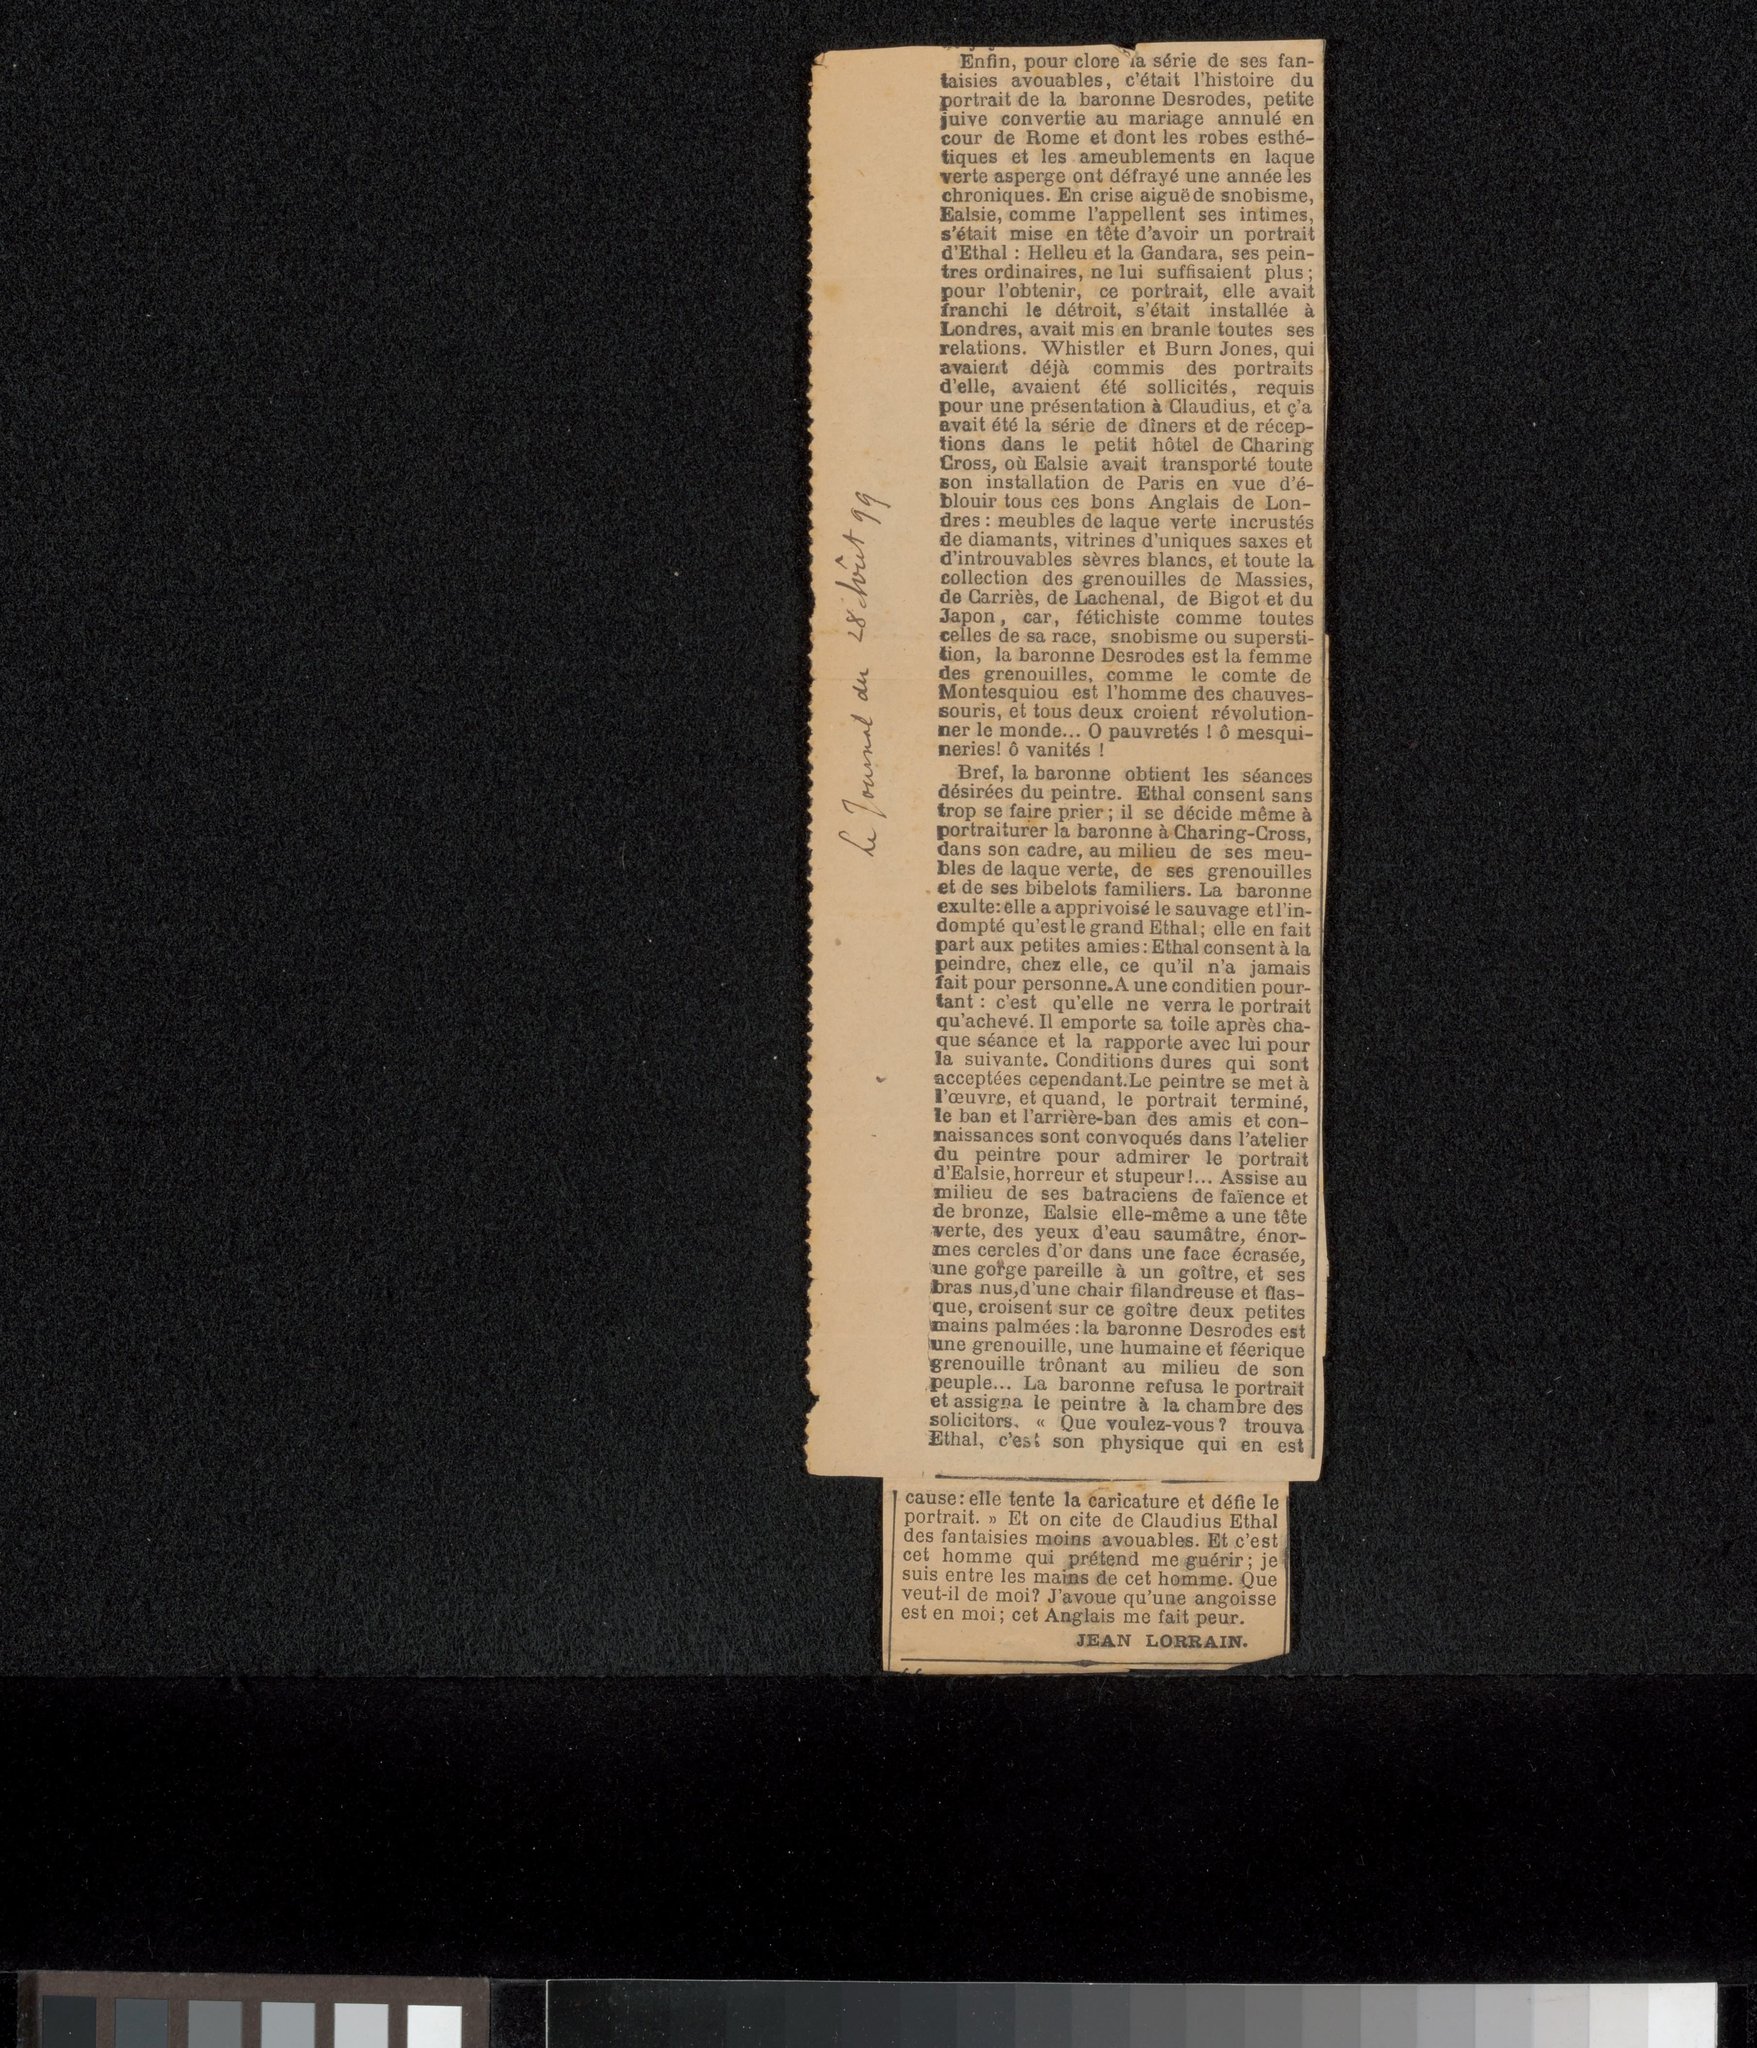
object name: newspaper clipping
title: Krantenknipsel uit archief Philip Zilcken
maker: Anonymous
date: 1867-1930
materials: paper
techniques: printing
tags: baronne madeleine deslandes, the hague, painter, draughtsman, philip zilcken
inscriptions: collector's mark: ‘RPK’